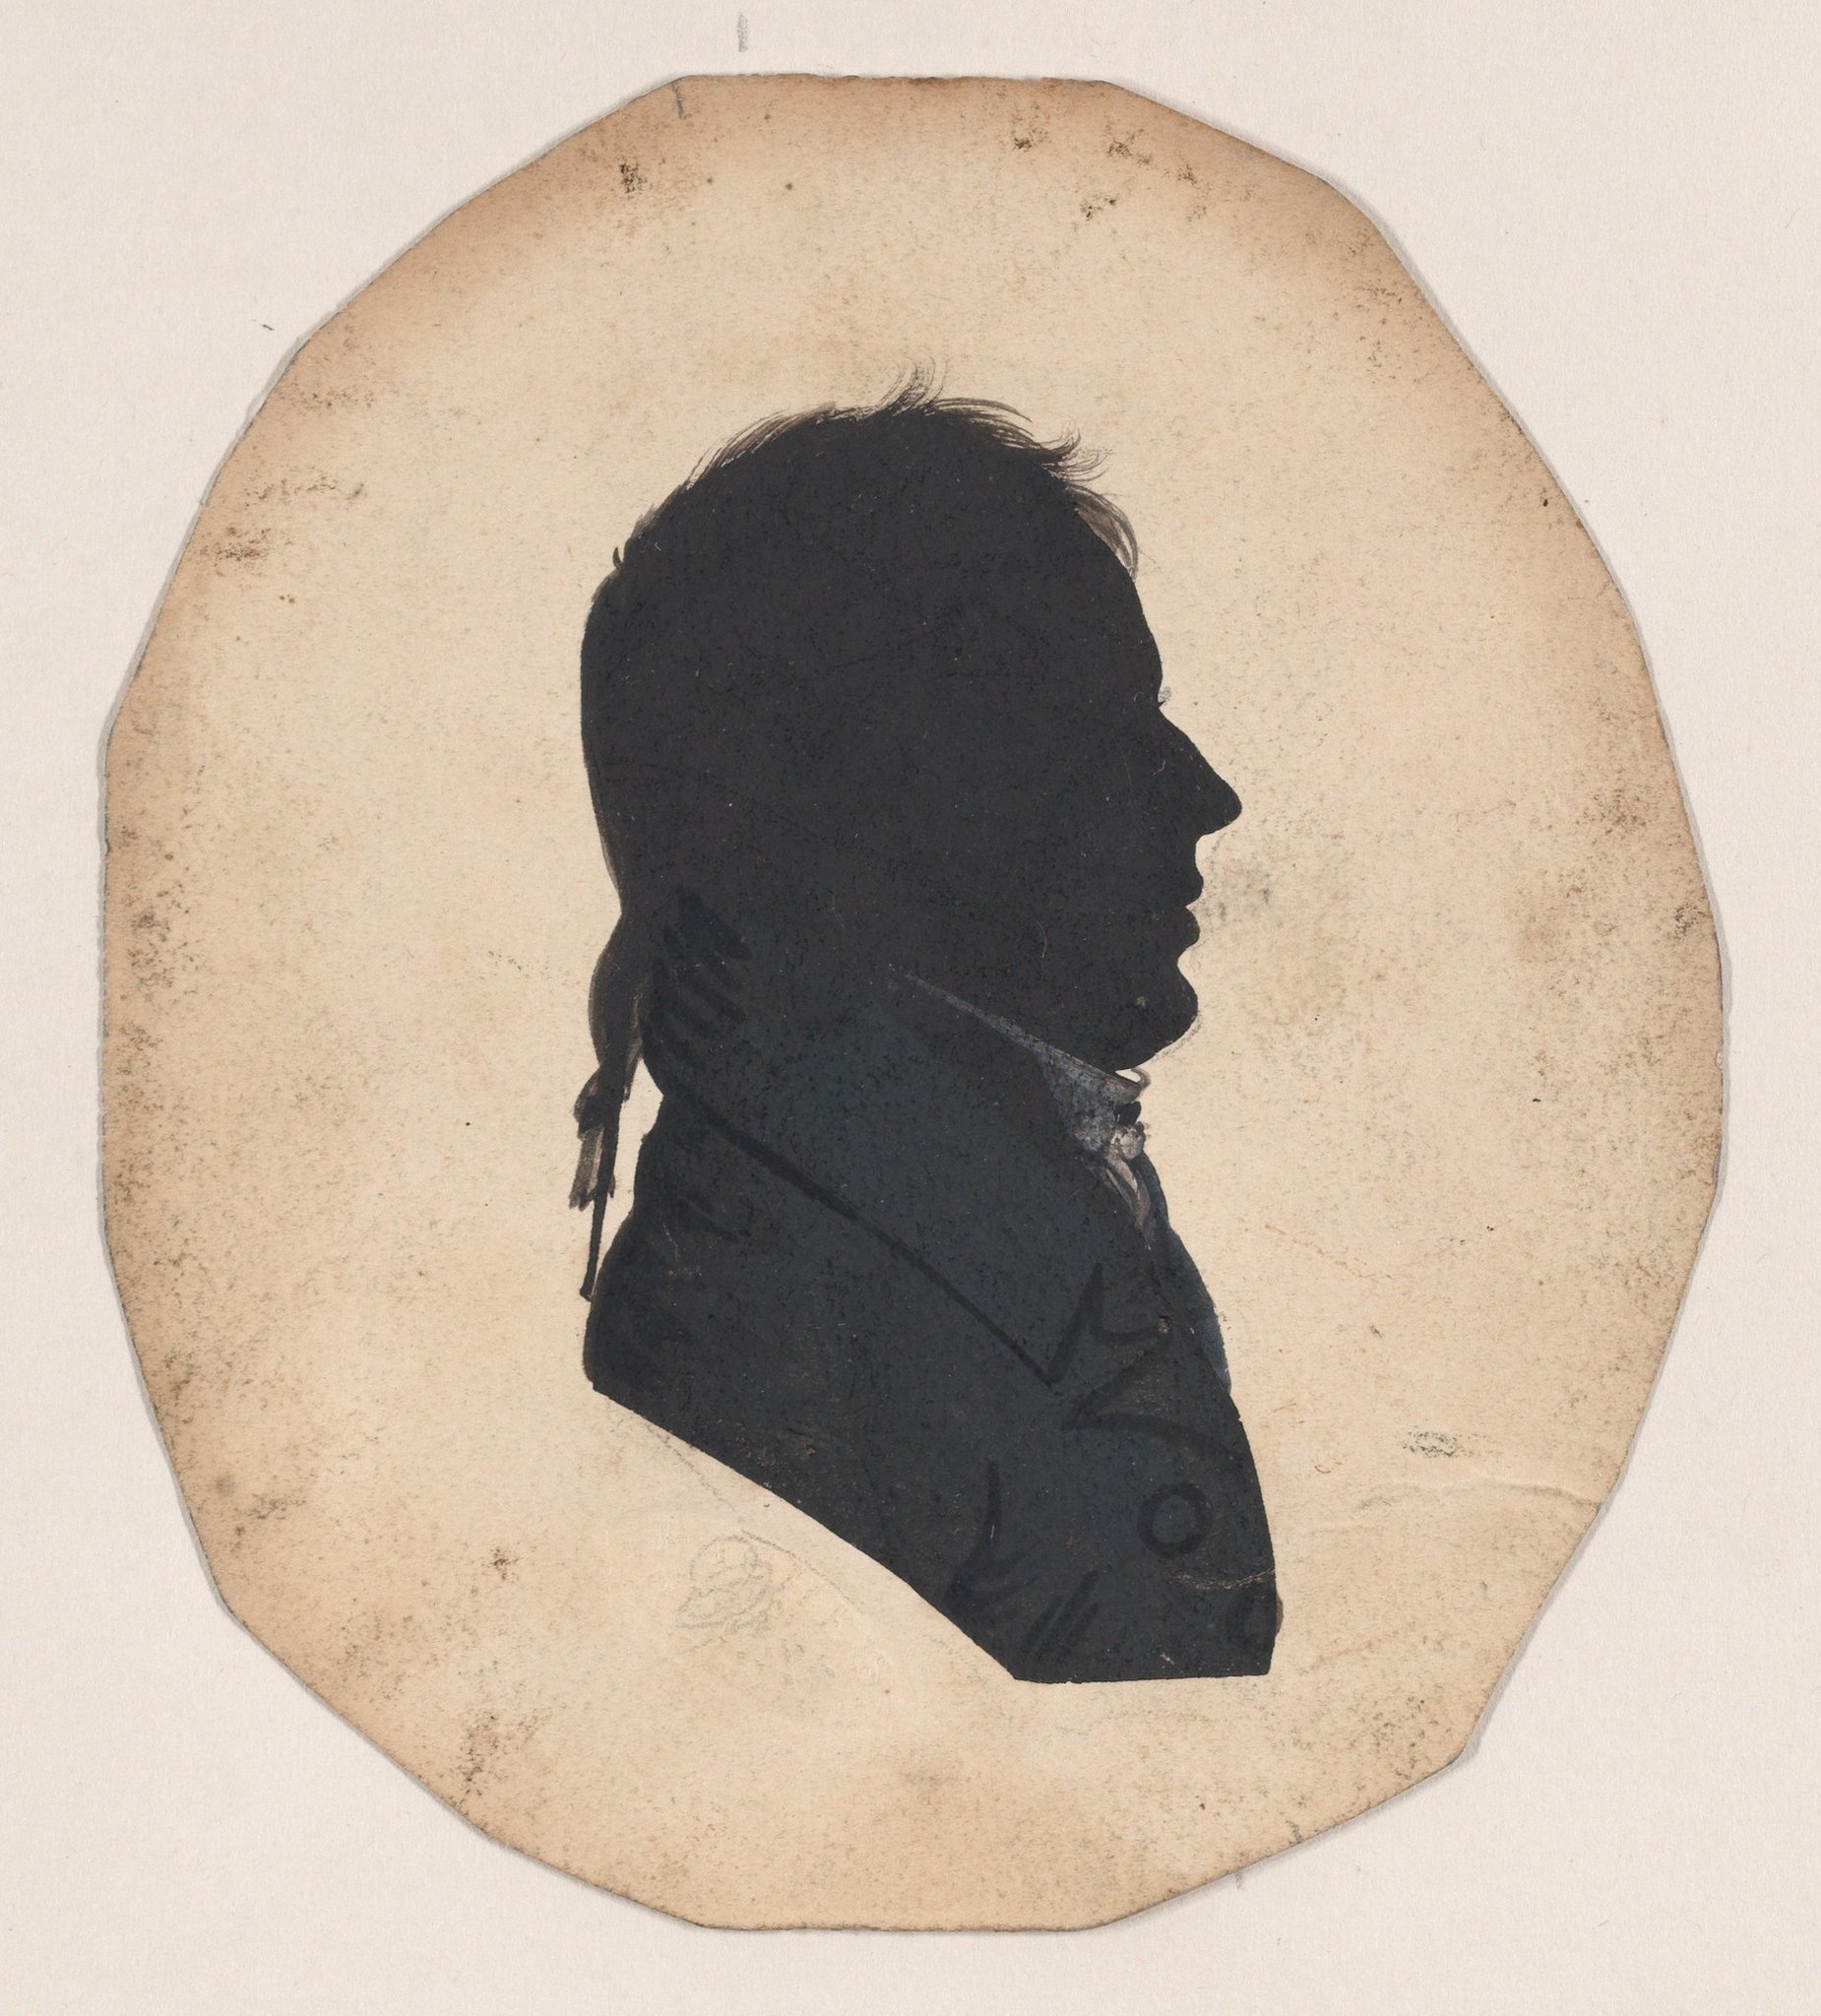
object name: drawing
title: Silhouette of an unknown man, in profile to the right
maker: william bache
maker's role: artist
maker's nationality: american, born england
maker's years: 1771-1845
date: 1801-1900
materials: ink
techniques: pen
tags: men